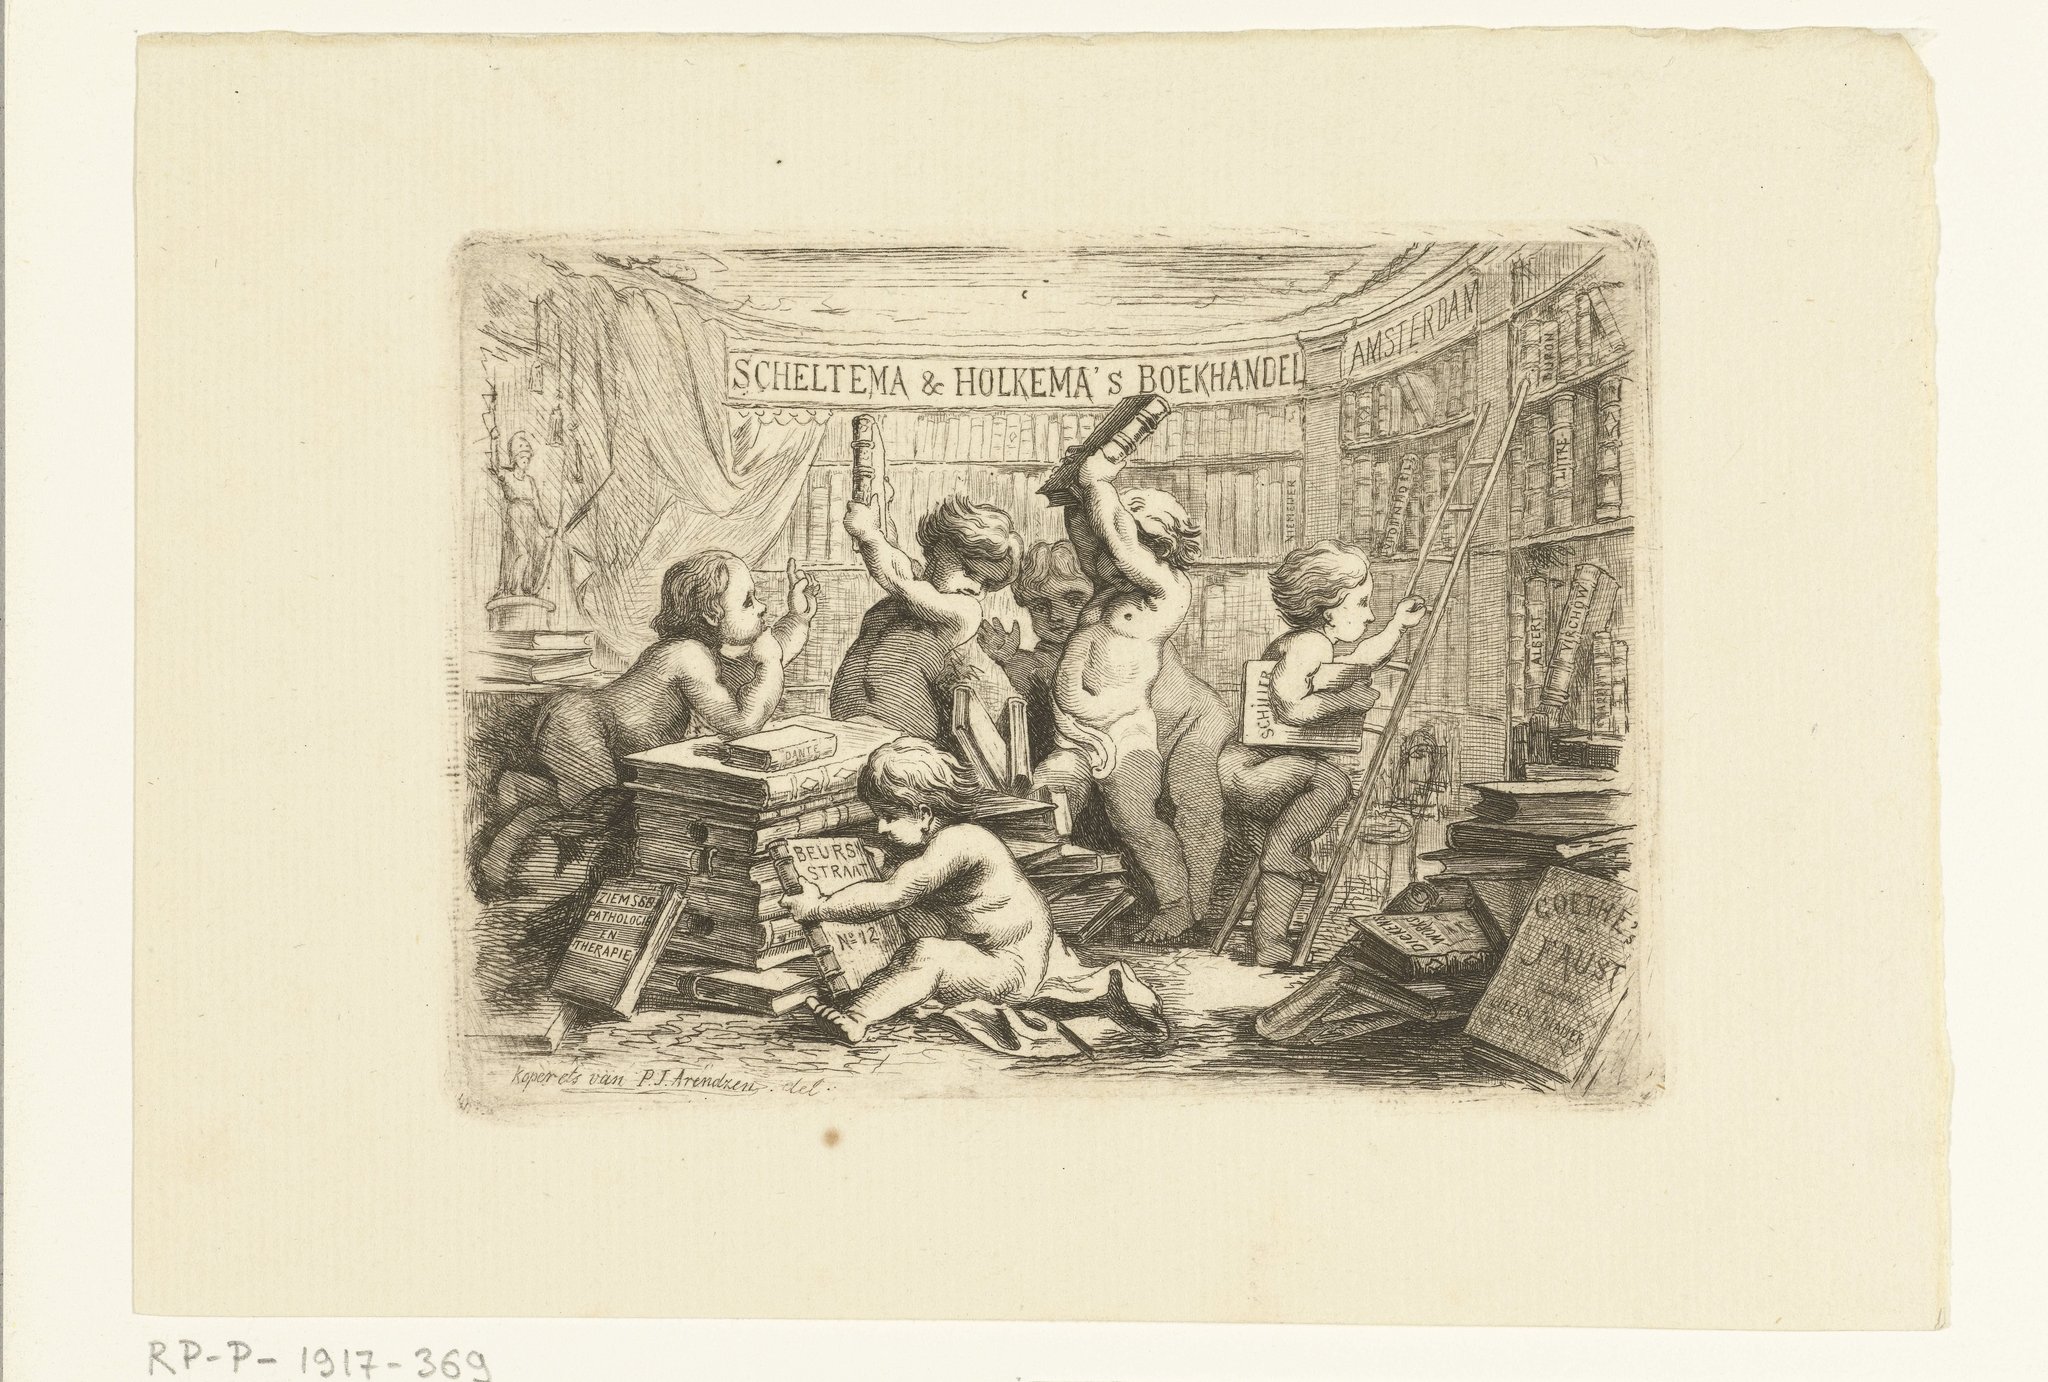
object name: print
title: Adreskaart voor boekhandel Scheltema en Holkema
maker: petrus johannes arendzen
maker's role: draughtsman, print maker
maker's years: 1846-1932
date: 1856-1917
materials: paper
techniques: drypoint, etching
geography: amsterdam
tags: book-shop, bookseller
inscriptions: collector's mark: Lugt 2228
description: Zes putti die in een boekwinkel spelen. De naam van de winkel staat op de bovenlijst van de boekenkasten, het adres van de winkel op de band van een boek.